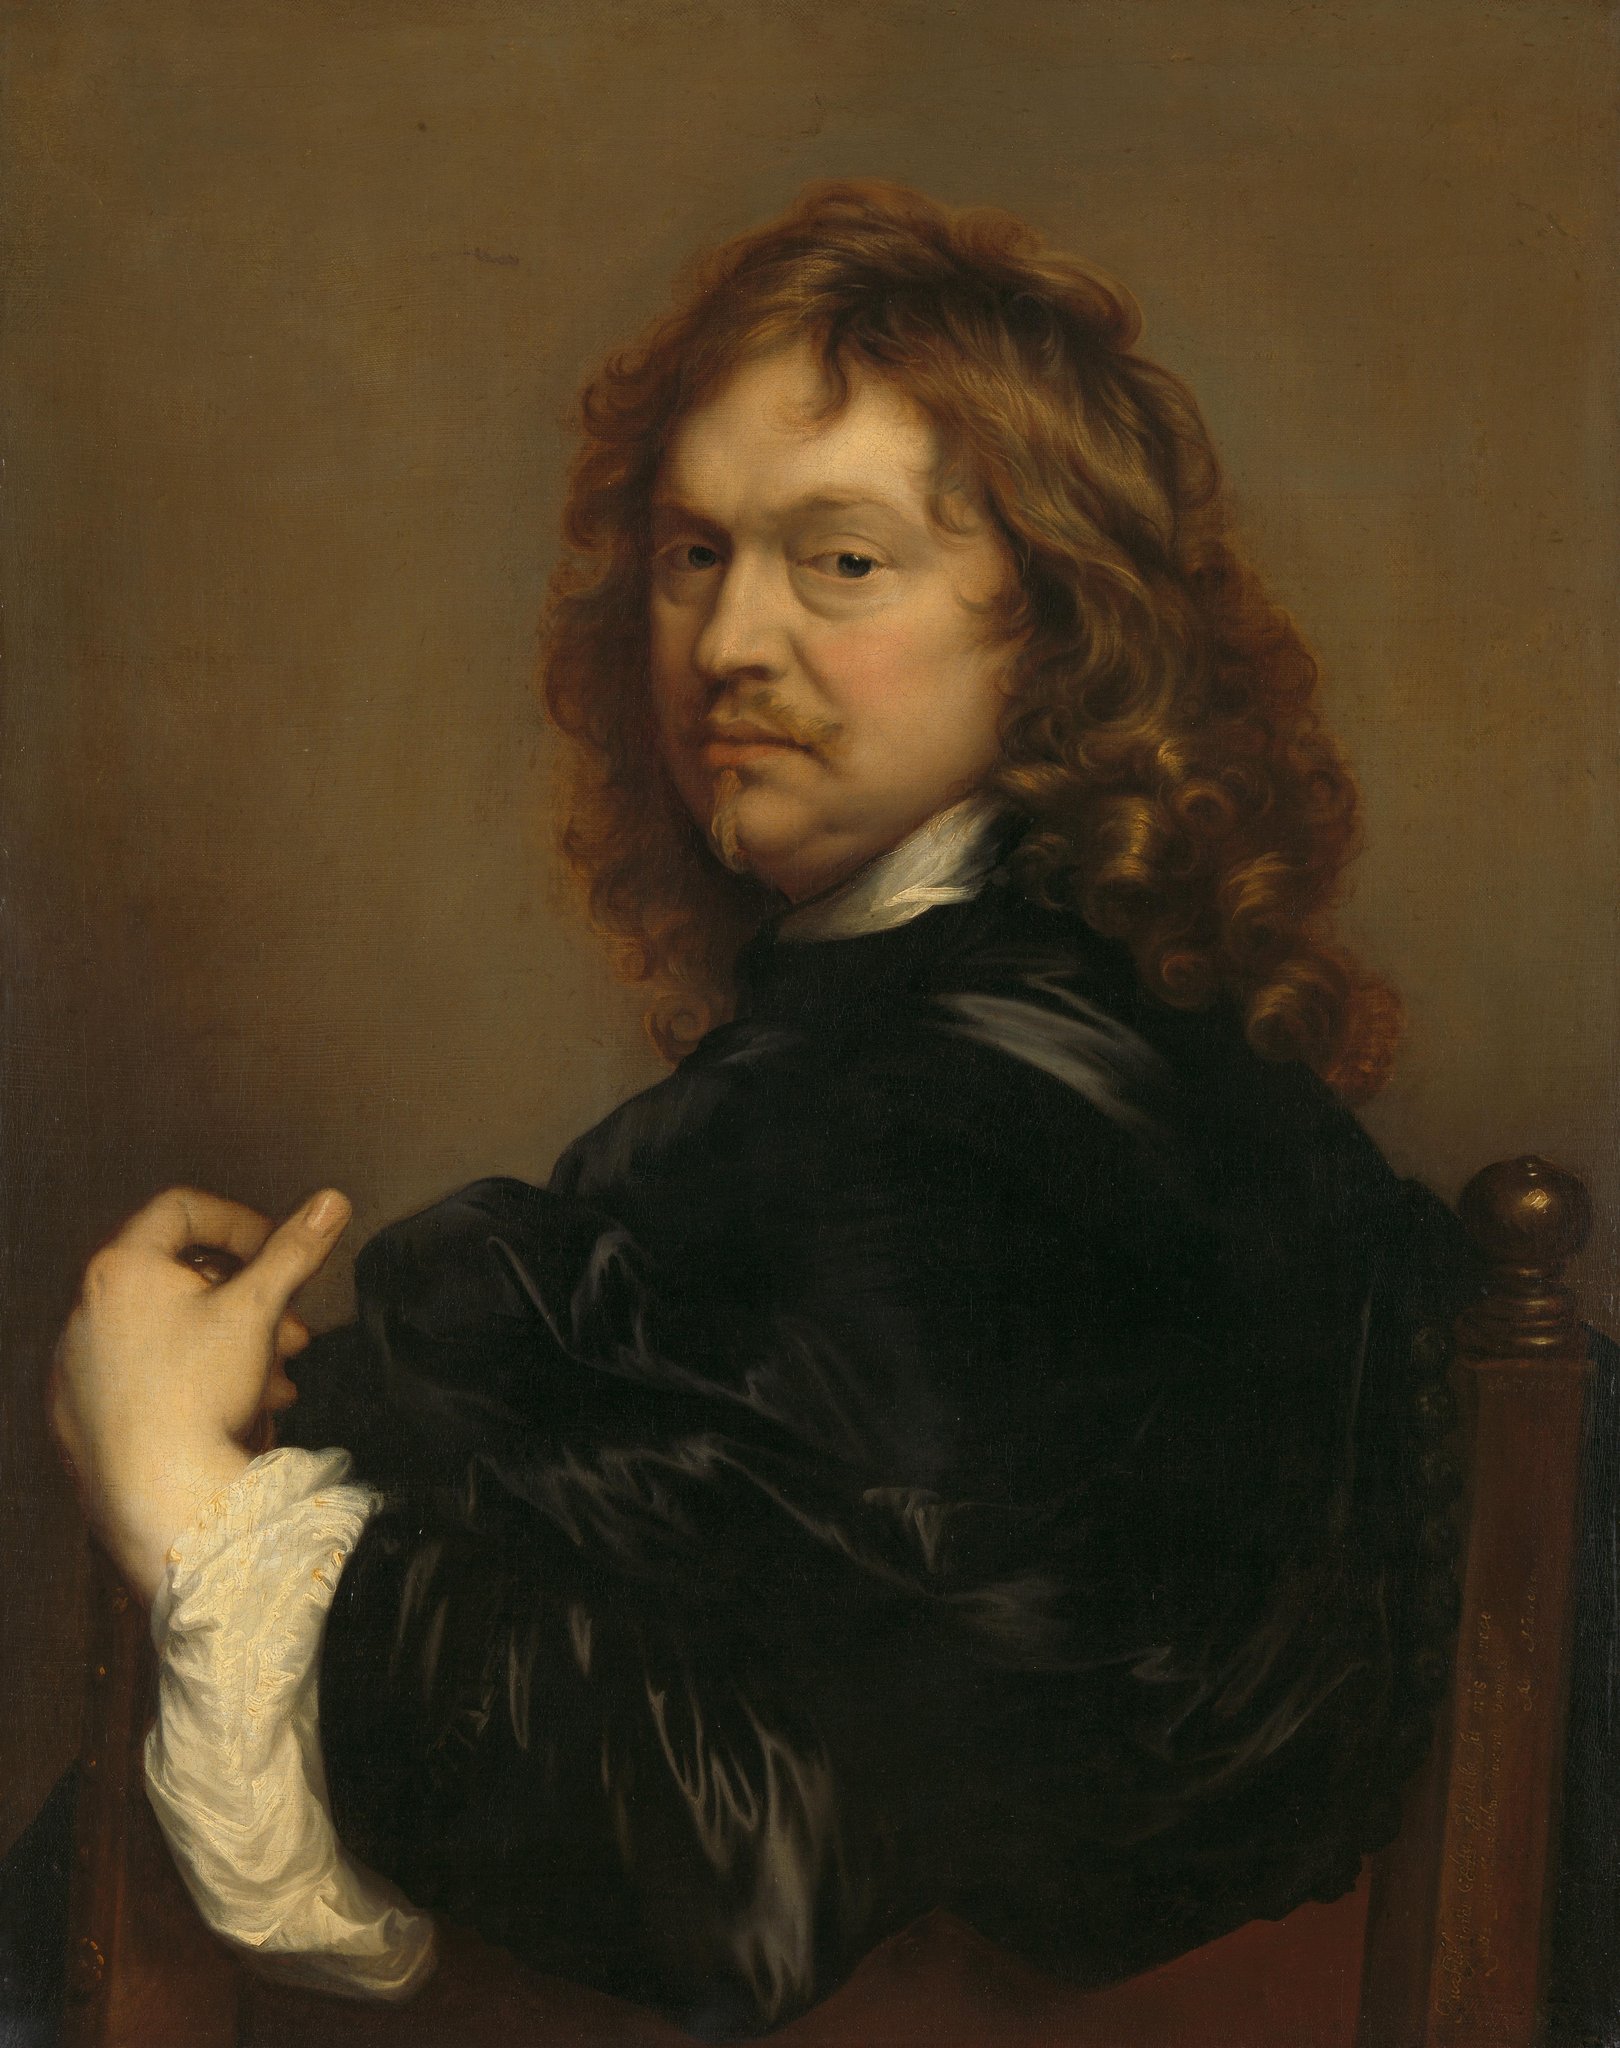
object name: painting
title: Self-Portrait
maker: adriaen hanneman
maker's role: painter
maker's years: 1603-1671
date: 1656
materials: canvas, oil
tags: adriaen hanneman, historical persons, portrait, self-portrait of painter, portrait, self-portrait of artist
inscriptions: signature, date and inscription, lower right, on the chair: ‘AN°: 1656. / Quaeris qui[s] [vu]ltus ductique sit oris imago / aere quis hanc talem duxerit inven[ie]s Adr. Hanneman’, inscription, underneath (the rest illegible): ‘Effigies […]’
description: Zelfportret van de schilder Adriaen Hanneman. Buste naar links, zittend in een stoel met de linkerarm over de leuning van de stoel.